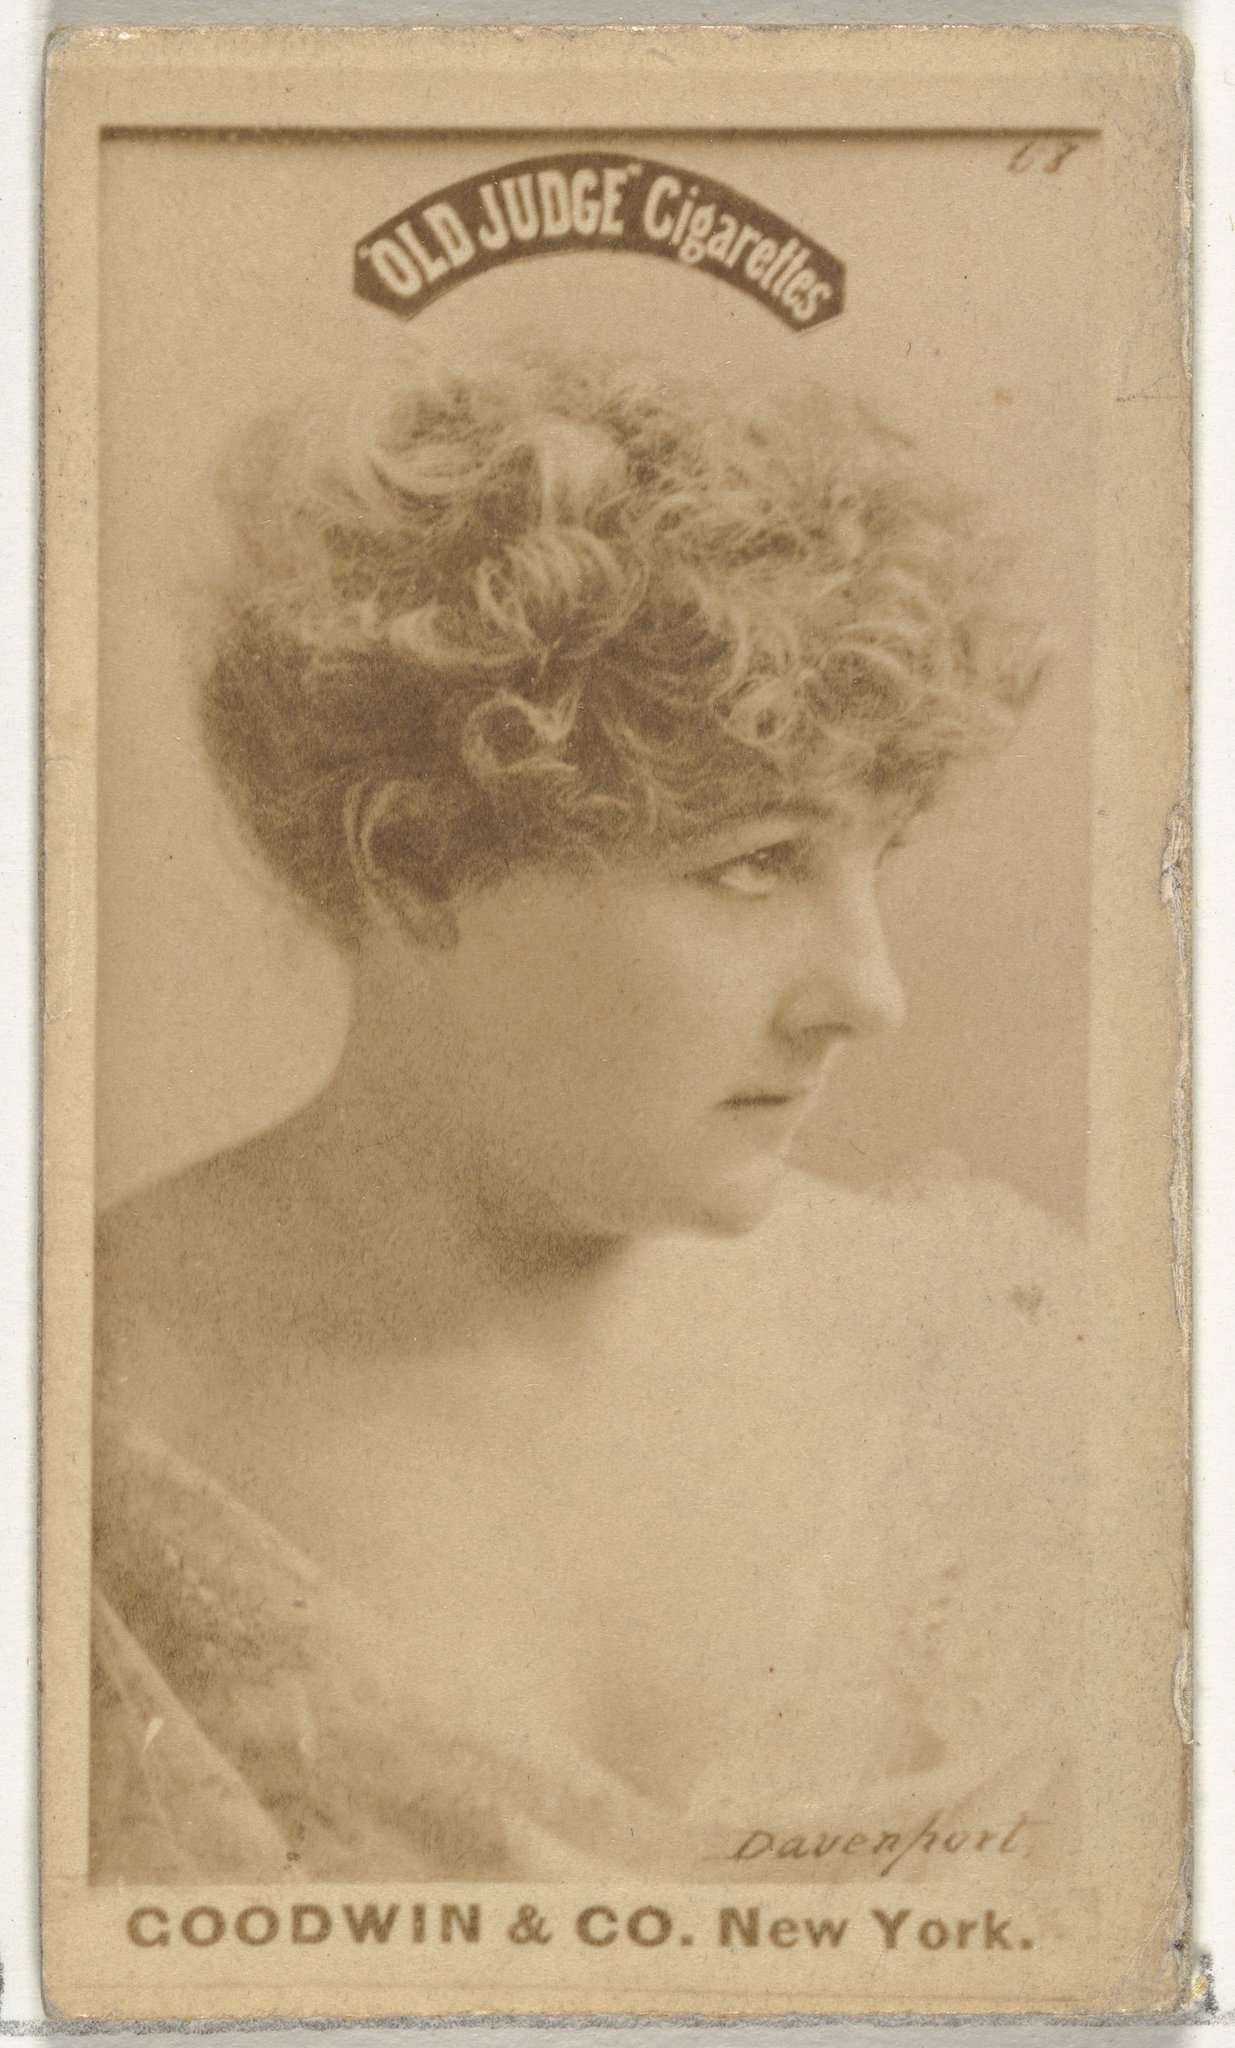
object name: photograph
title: Davenport, from the Actors and Actresses series (N171) for Old Judge Cigarettes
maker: goodwin & company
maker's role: publisher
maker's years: 1850-1950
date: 1886-1890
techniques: albumen silver print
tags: portraits,women,actresses